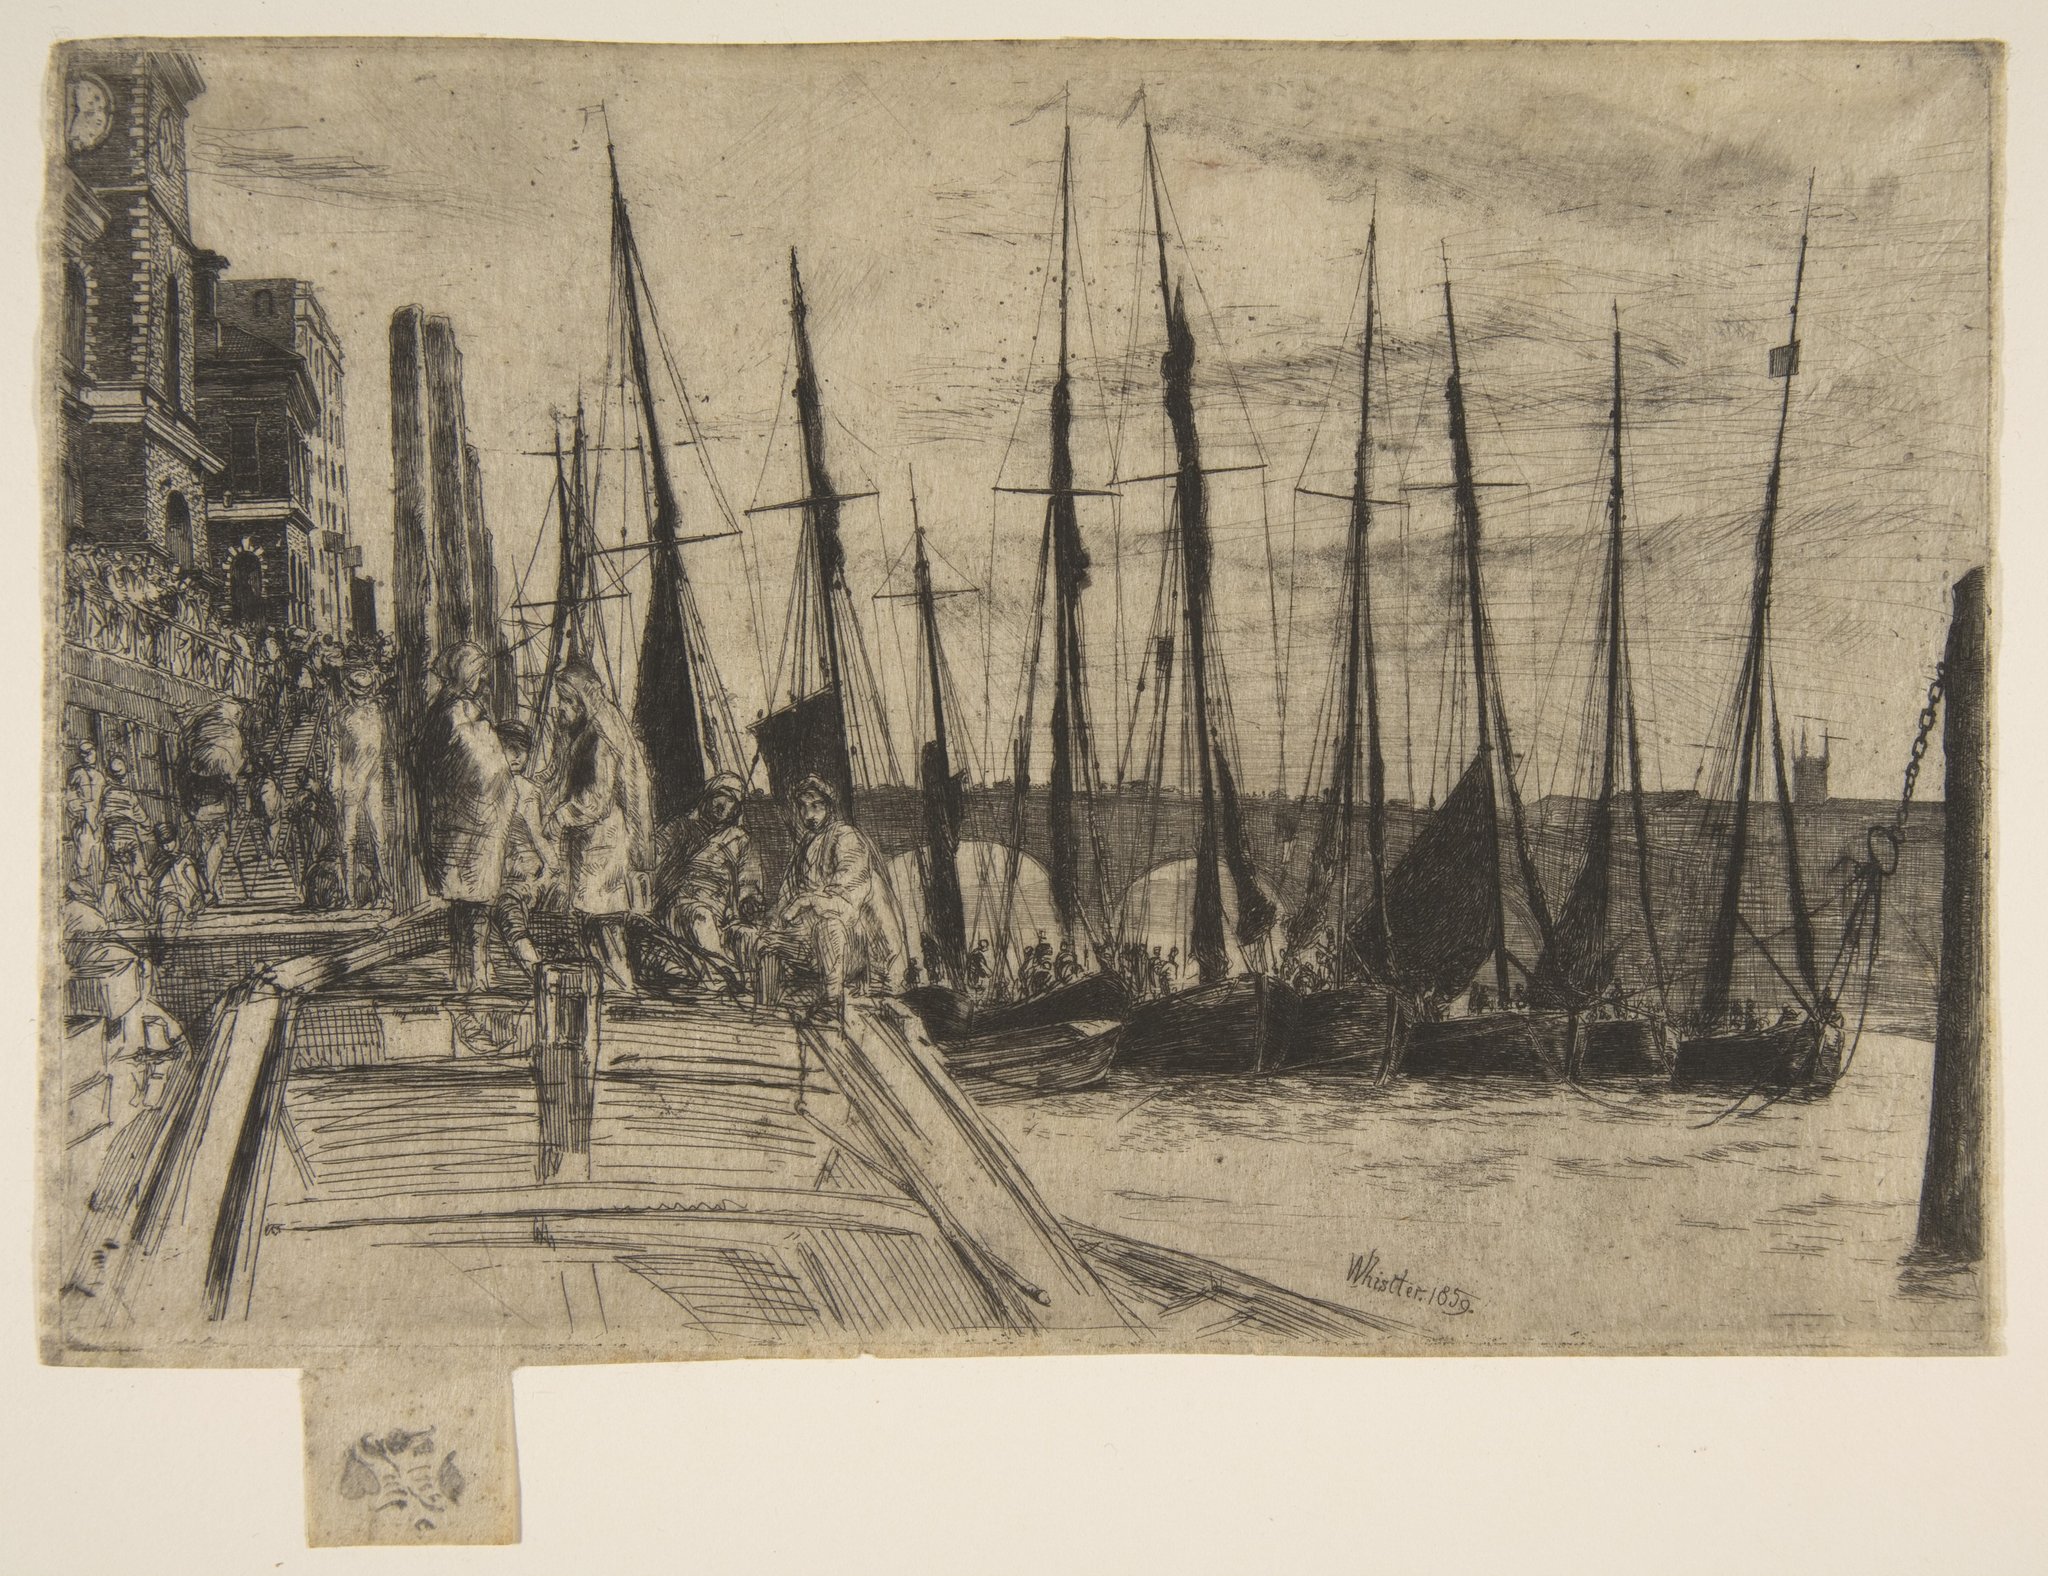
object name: print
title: Billingsgate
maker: james mcneill whistler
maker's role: artist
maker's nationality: american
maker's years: 1834-1903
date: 1859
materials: ink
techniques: drypoint, etching, printing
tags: buildings,boats,london